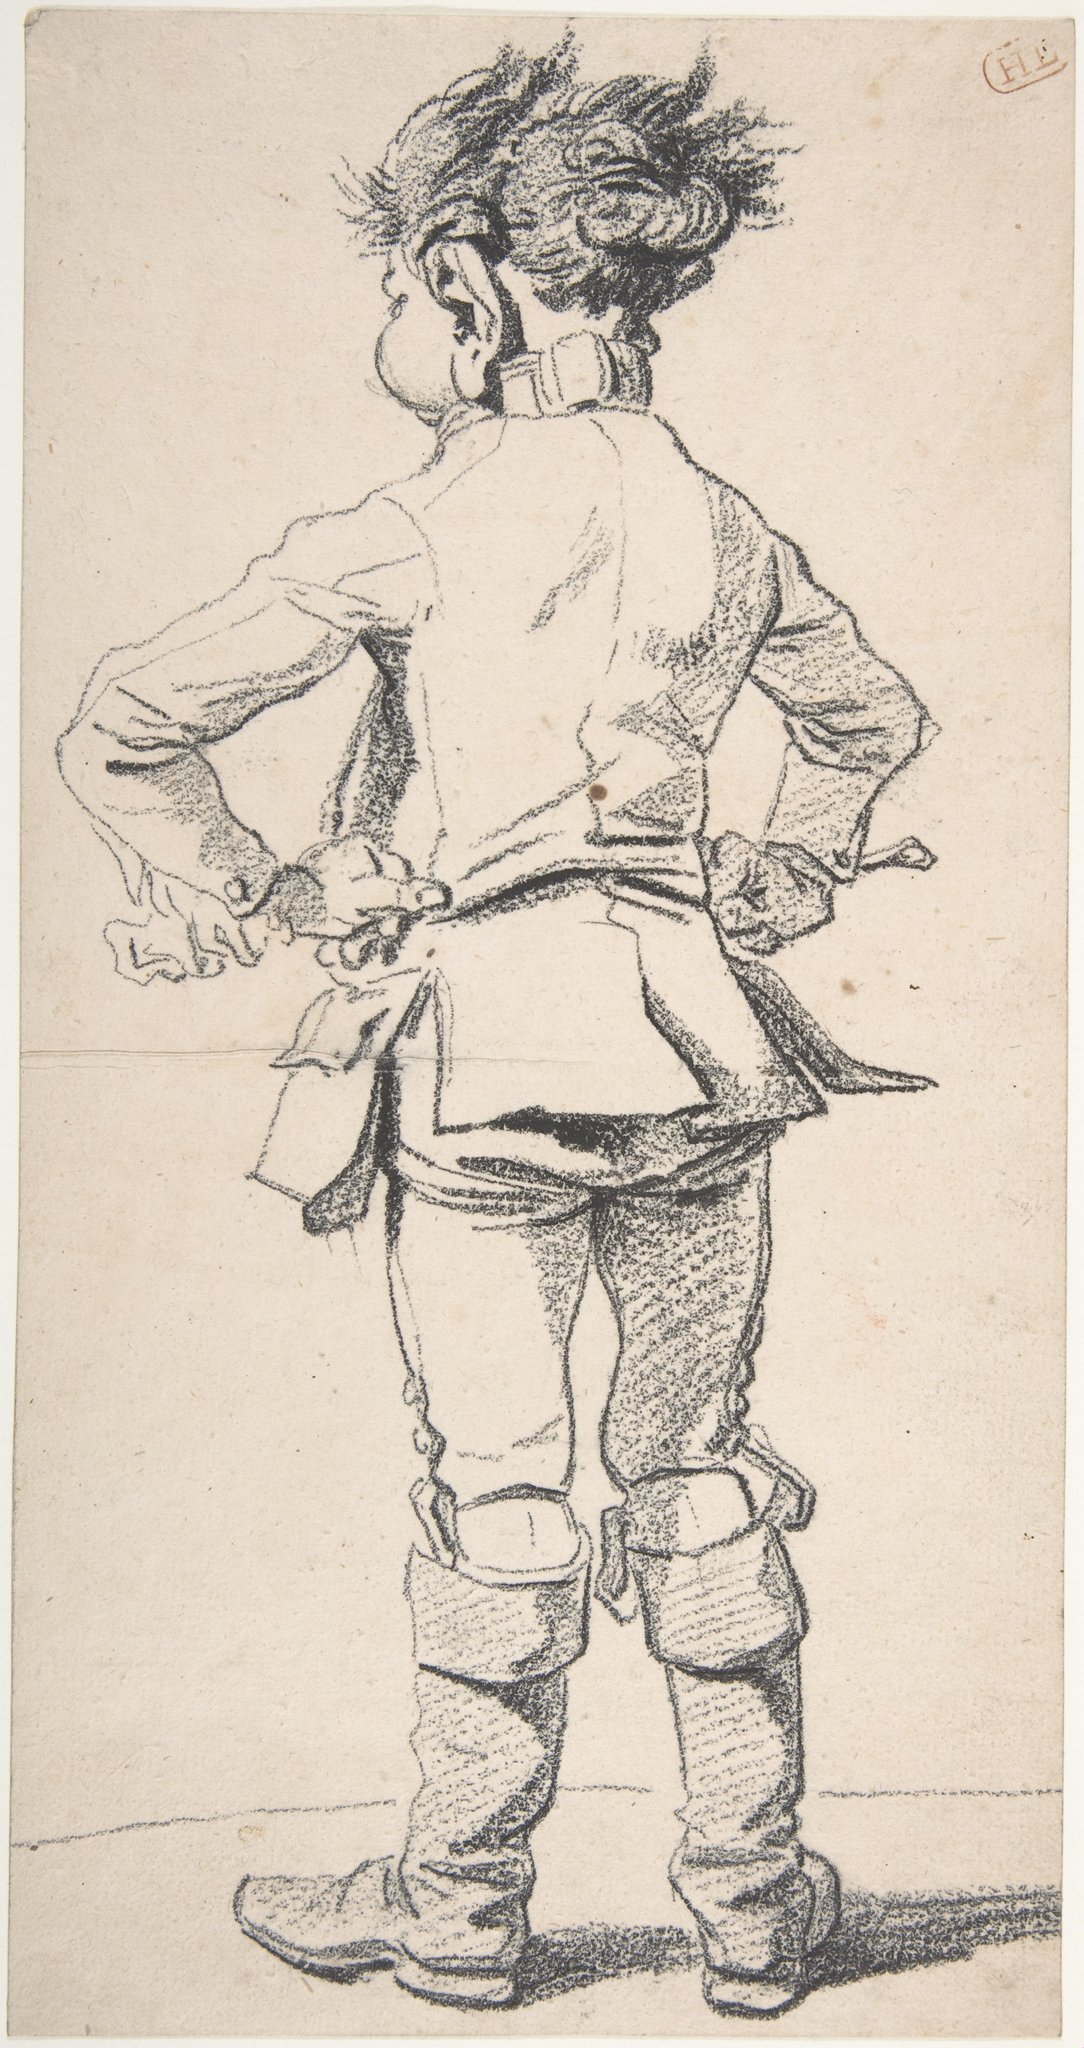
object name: drawing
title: Back View of a Roman Servant Boy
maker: françois andré vincent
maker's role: artist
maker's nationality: french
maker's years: 1746-1816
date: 1771-1775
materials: chalk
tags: boys,servants